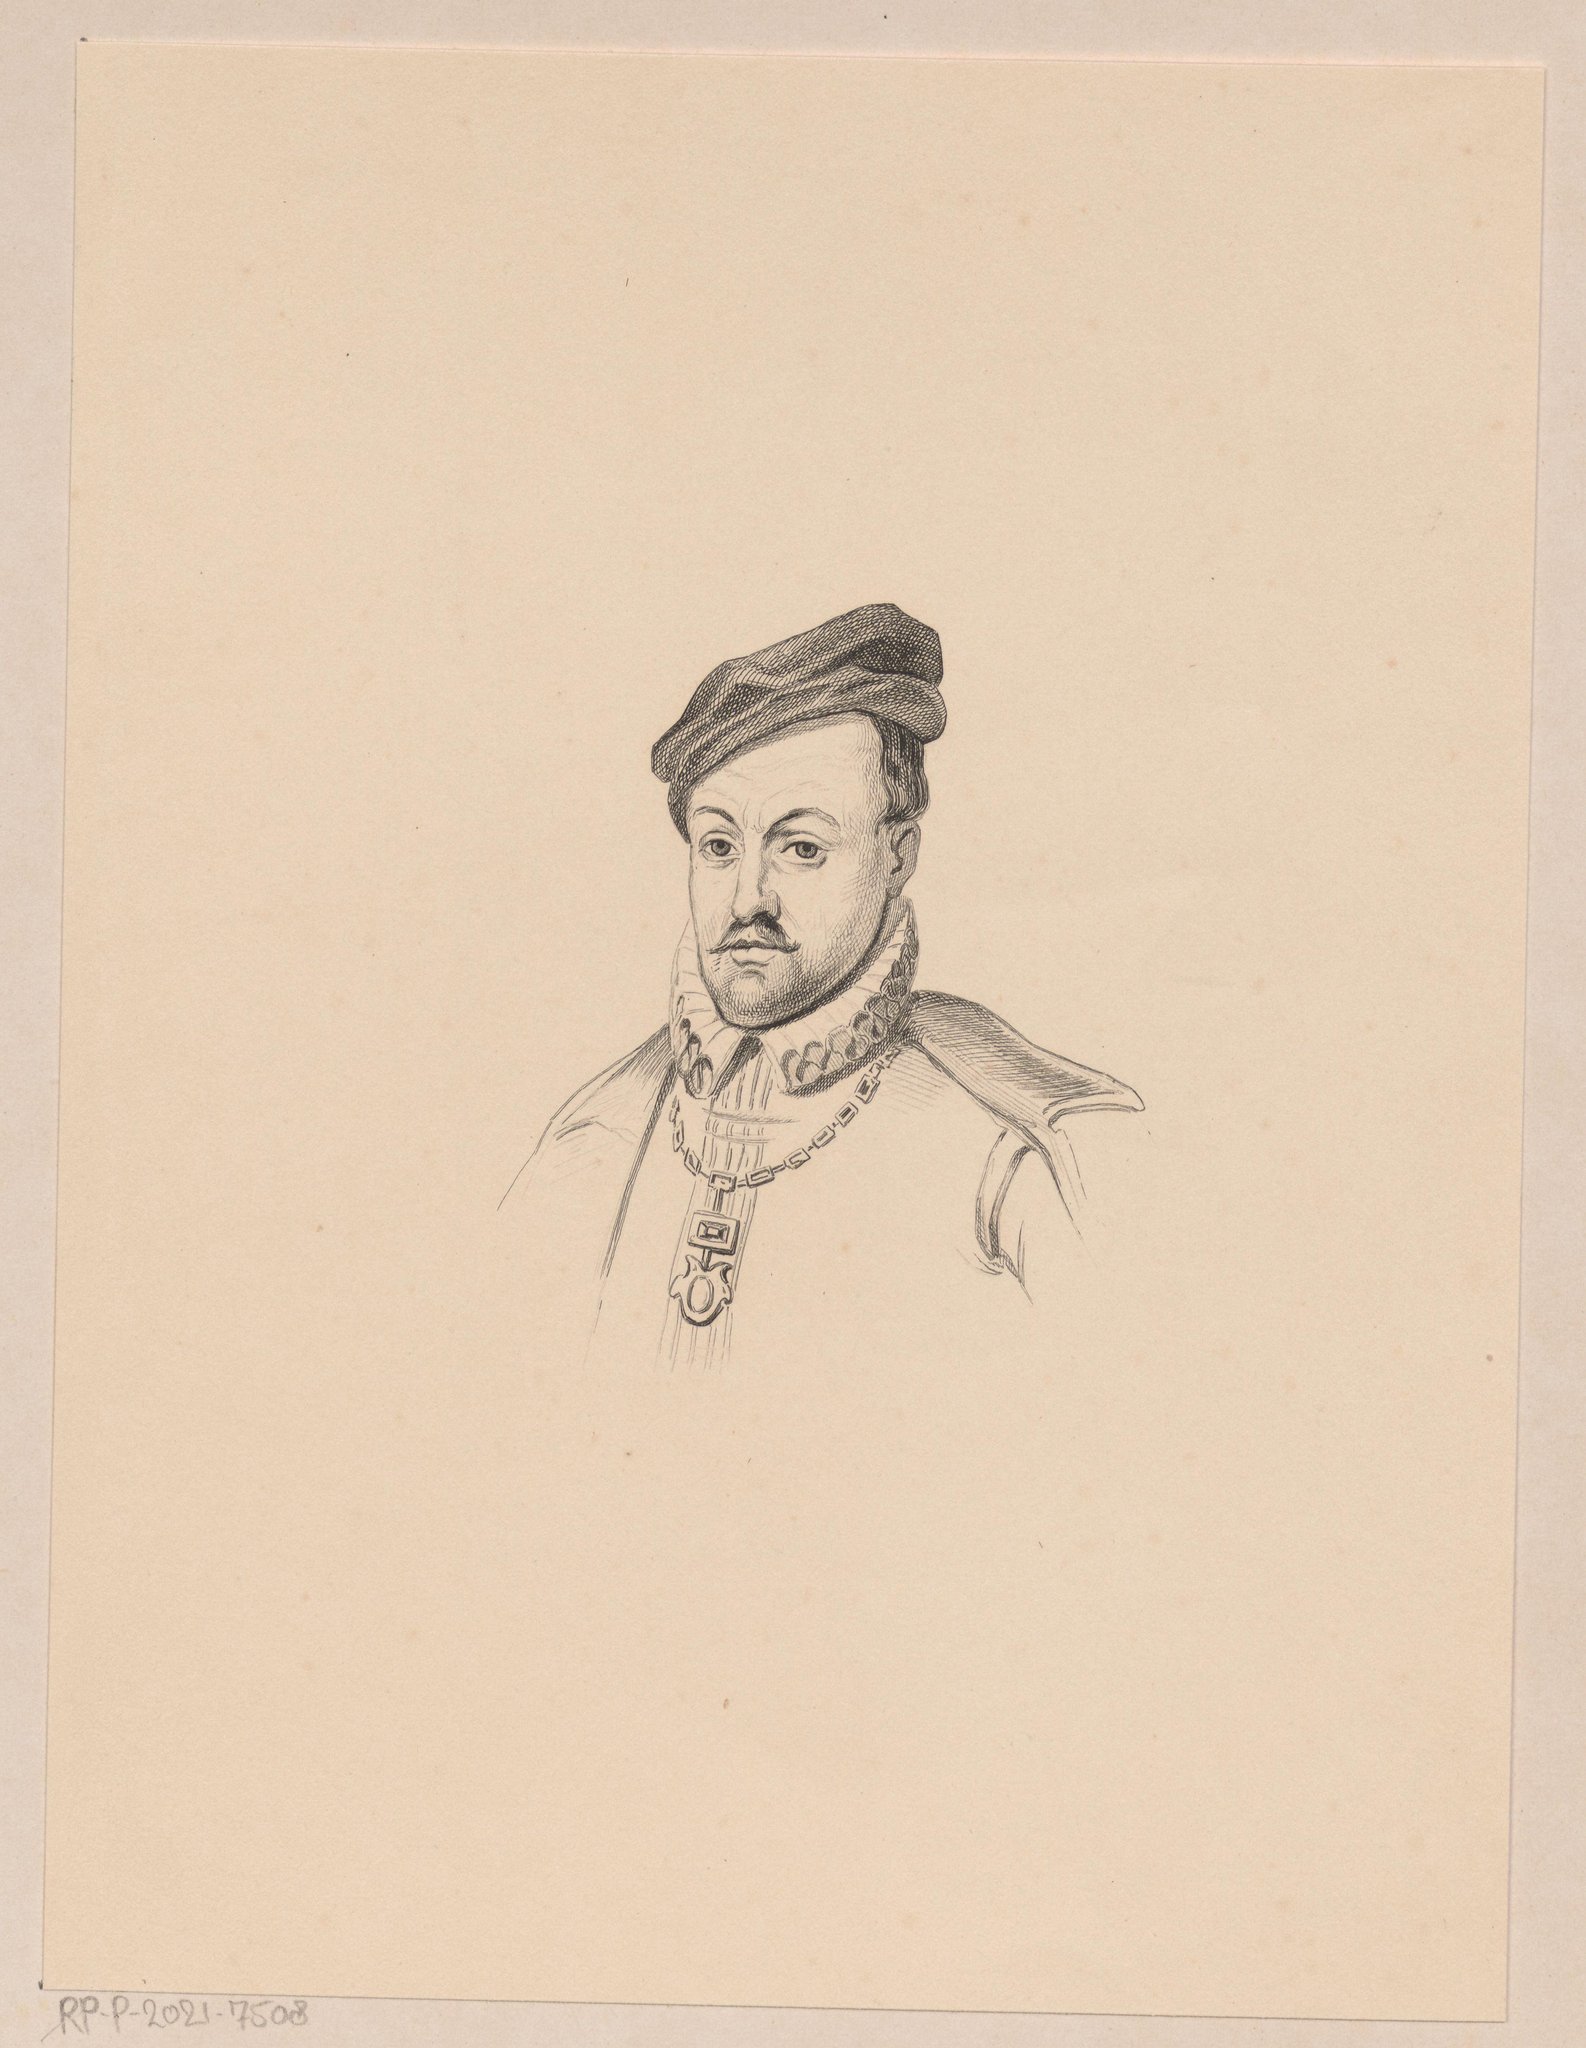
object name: print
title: Portret van Luis de Zúñiga y Requesens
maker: Anonymous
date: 1800-1849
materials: paper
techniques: etching, roulette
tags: brussels, mayor, luis de zúñiga y requesens, historical persons